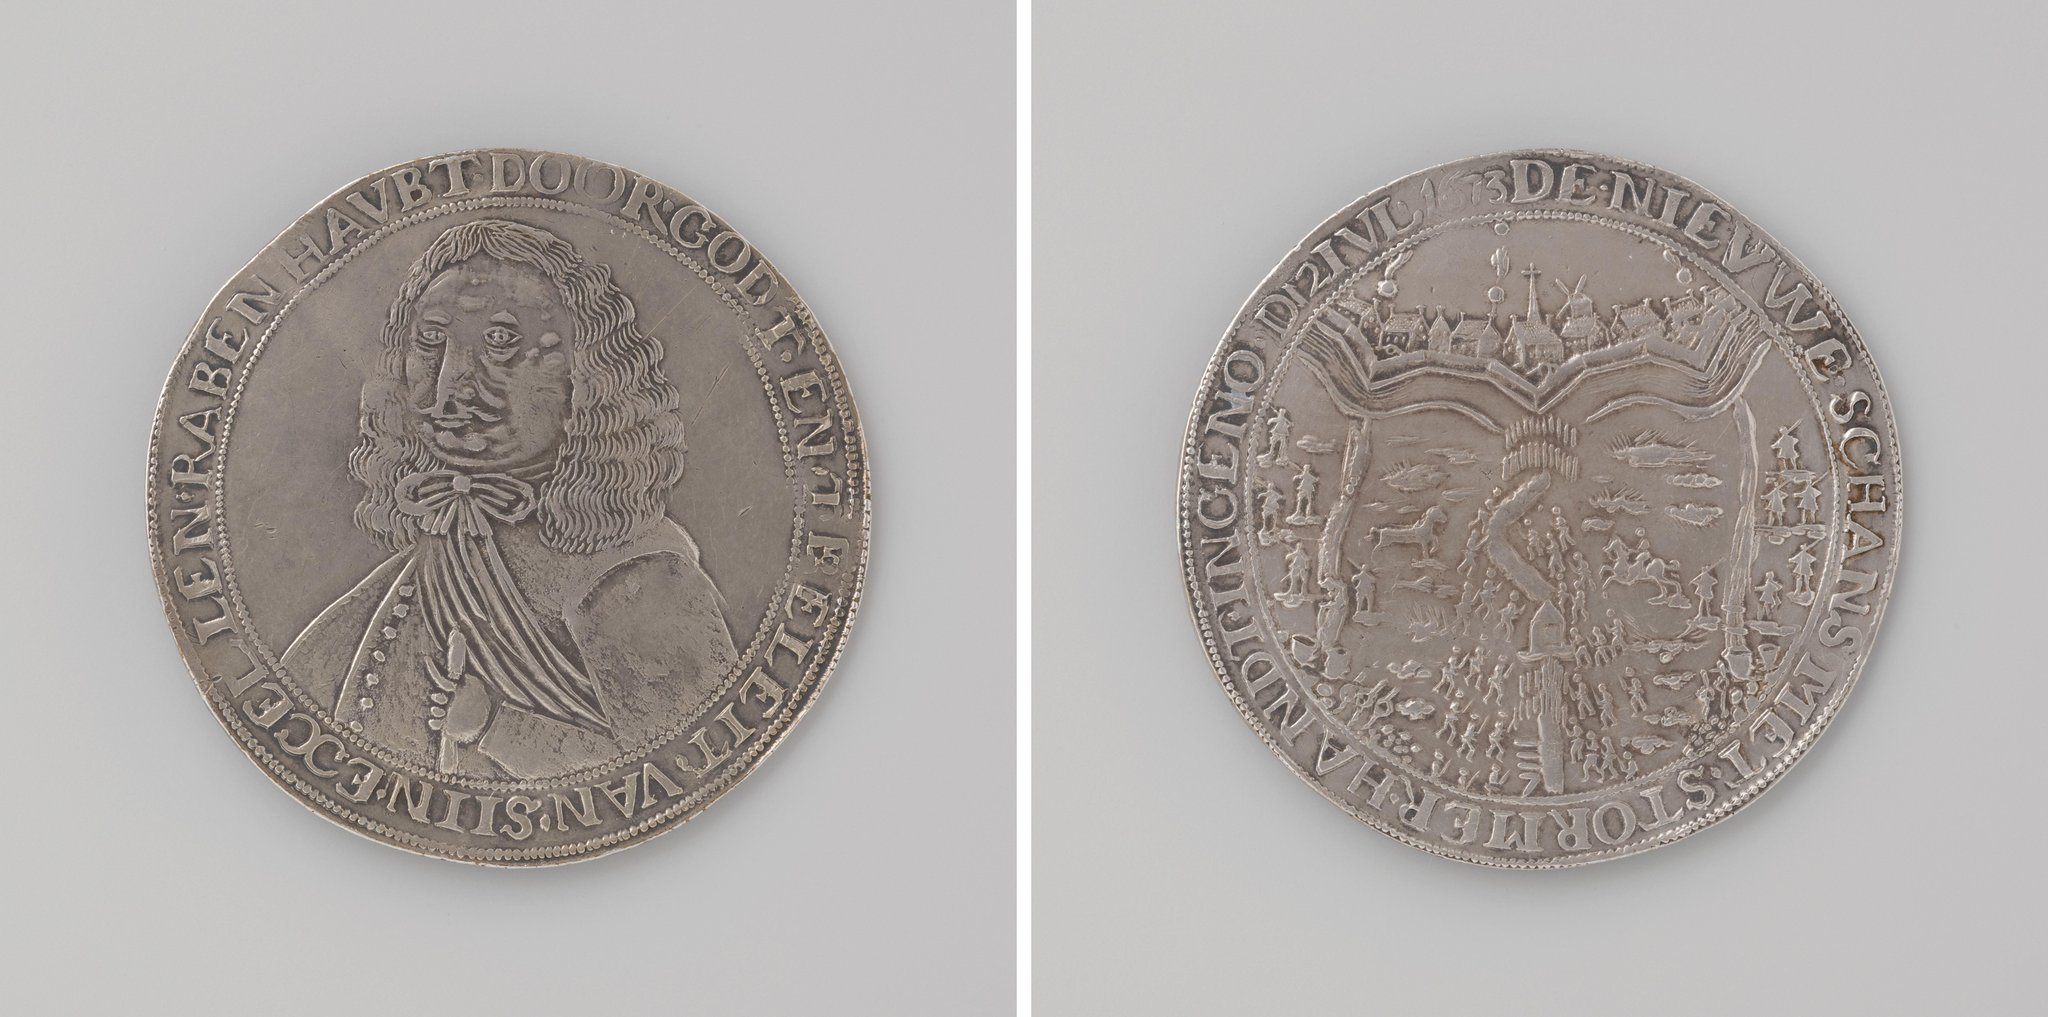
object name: history medal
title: Nieuweschans stormenderhand door Rabenhaupt ingenomen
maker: Anonymous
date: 1673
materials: silver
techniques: striking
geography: netherlands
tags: coevorden, gouverneur, karl rabenhaupt (baron von sucha), nieuweschans, inname van nieuweschans, guerre de hollande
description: Zilveren penning. Voorzijde: borststuk man binnen omschrift. Keerzijde: stad tijdens beschieting binnen omschrift.